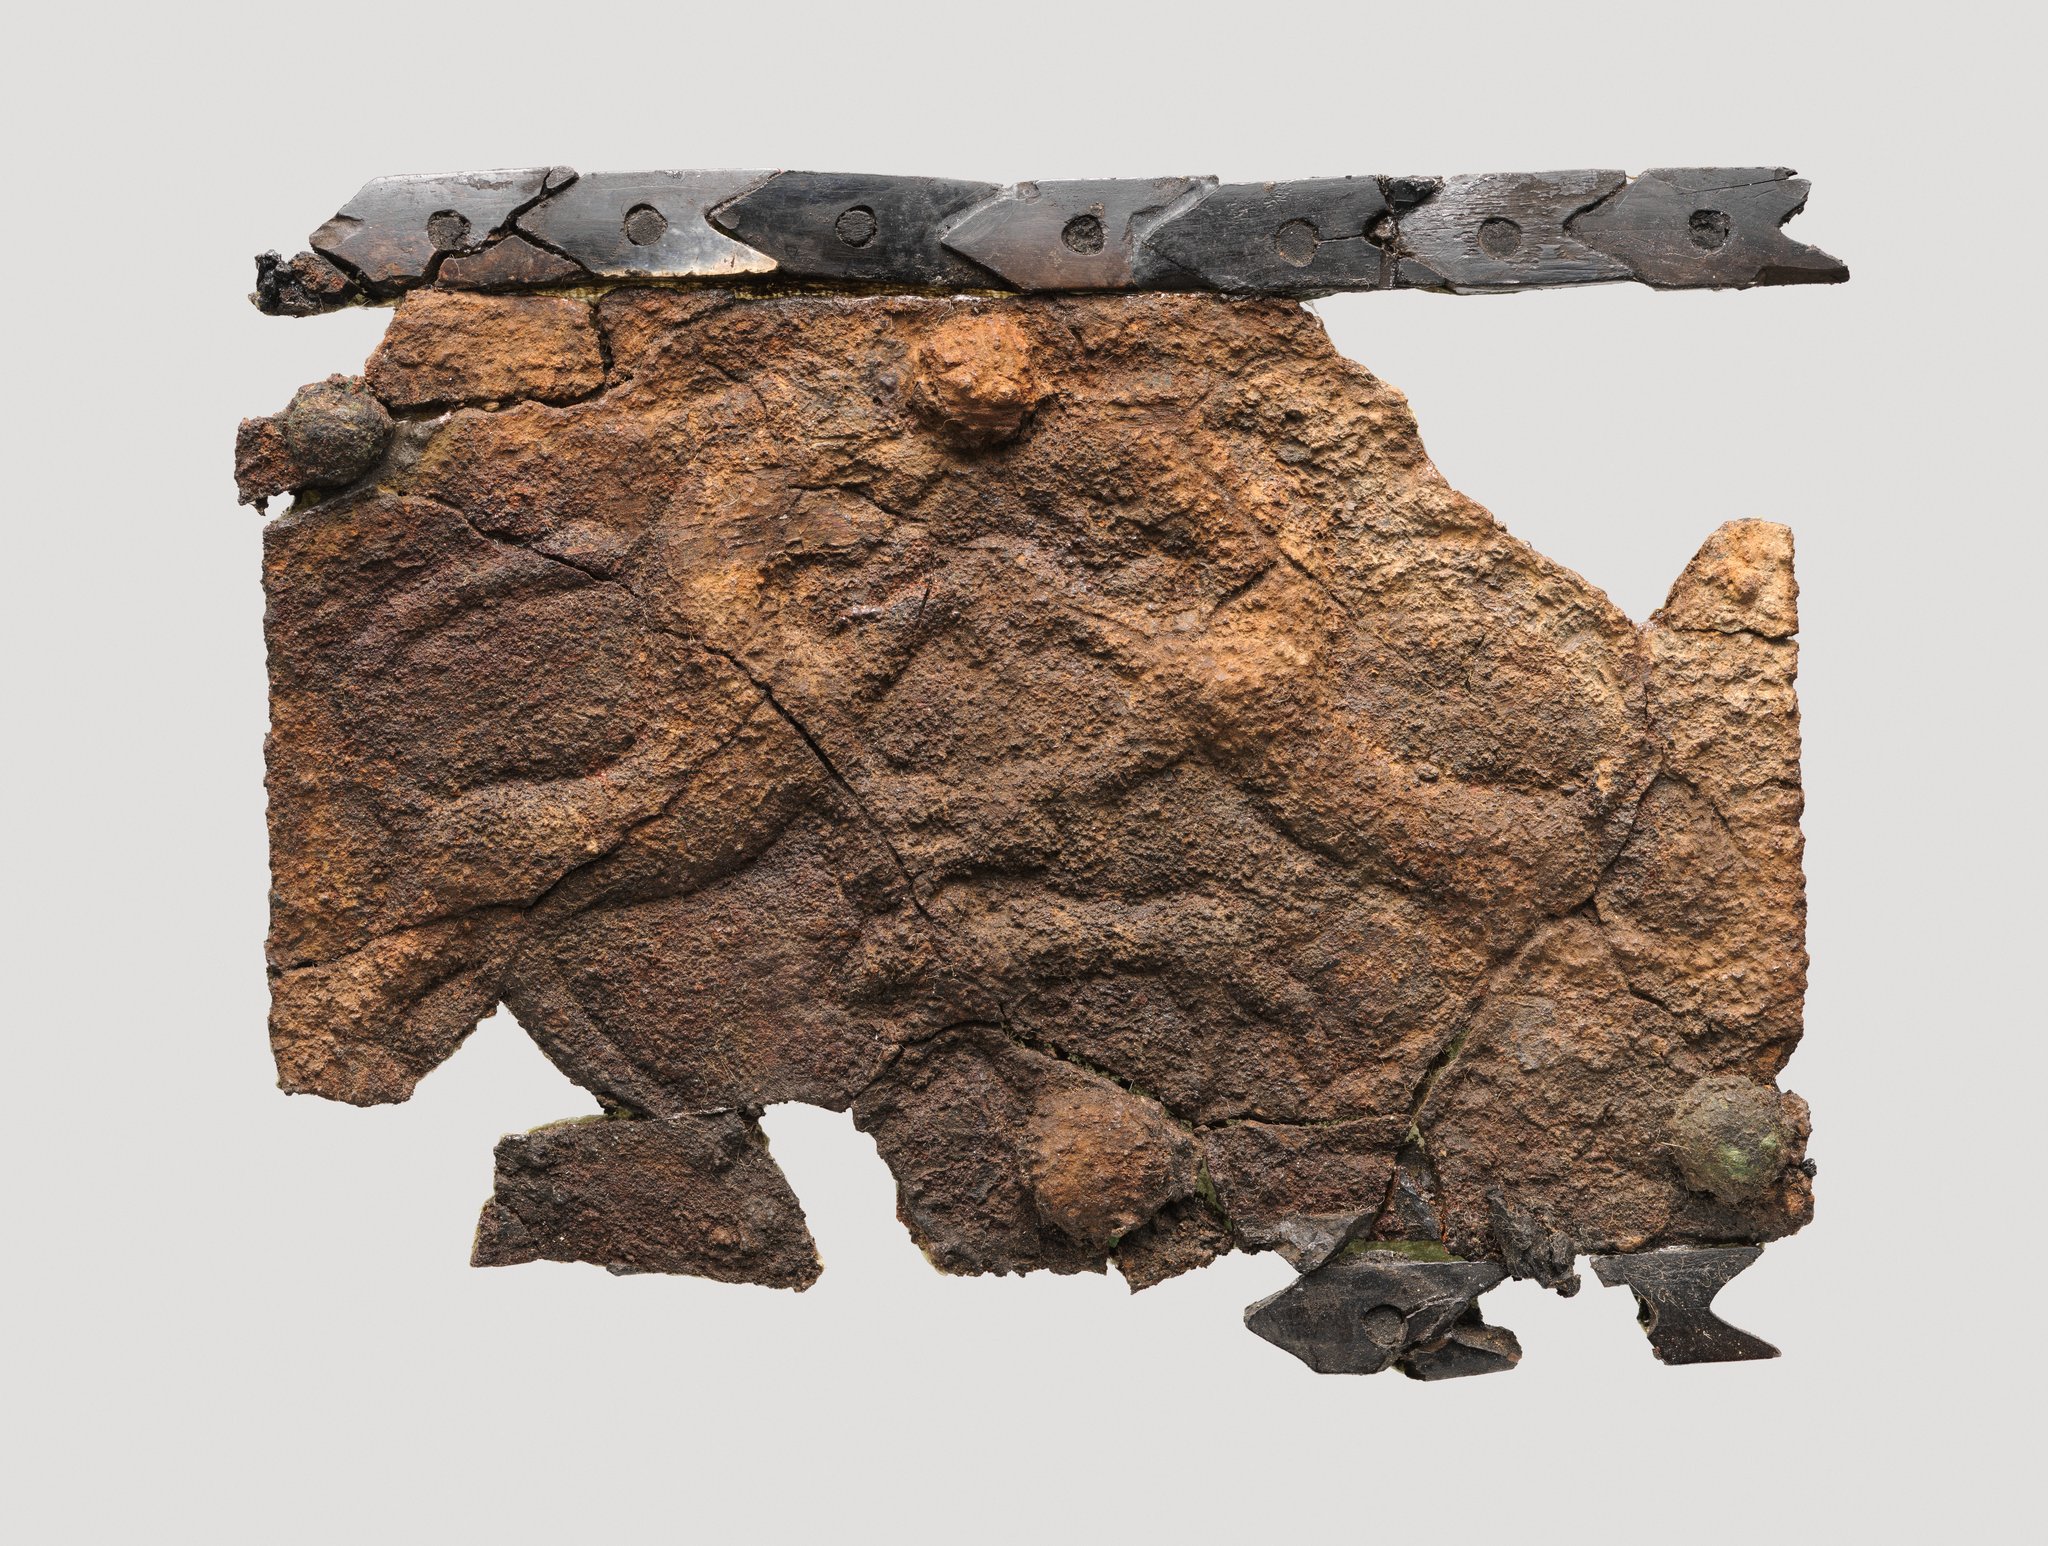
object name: relief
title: Plaque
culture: iranian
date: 900-801 BCE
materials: bone, iron, ivory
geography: iran